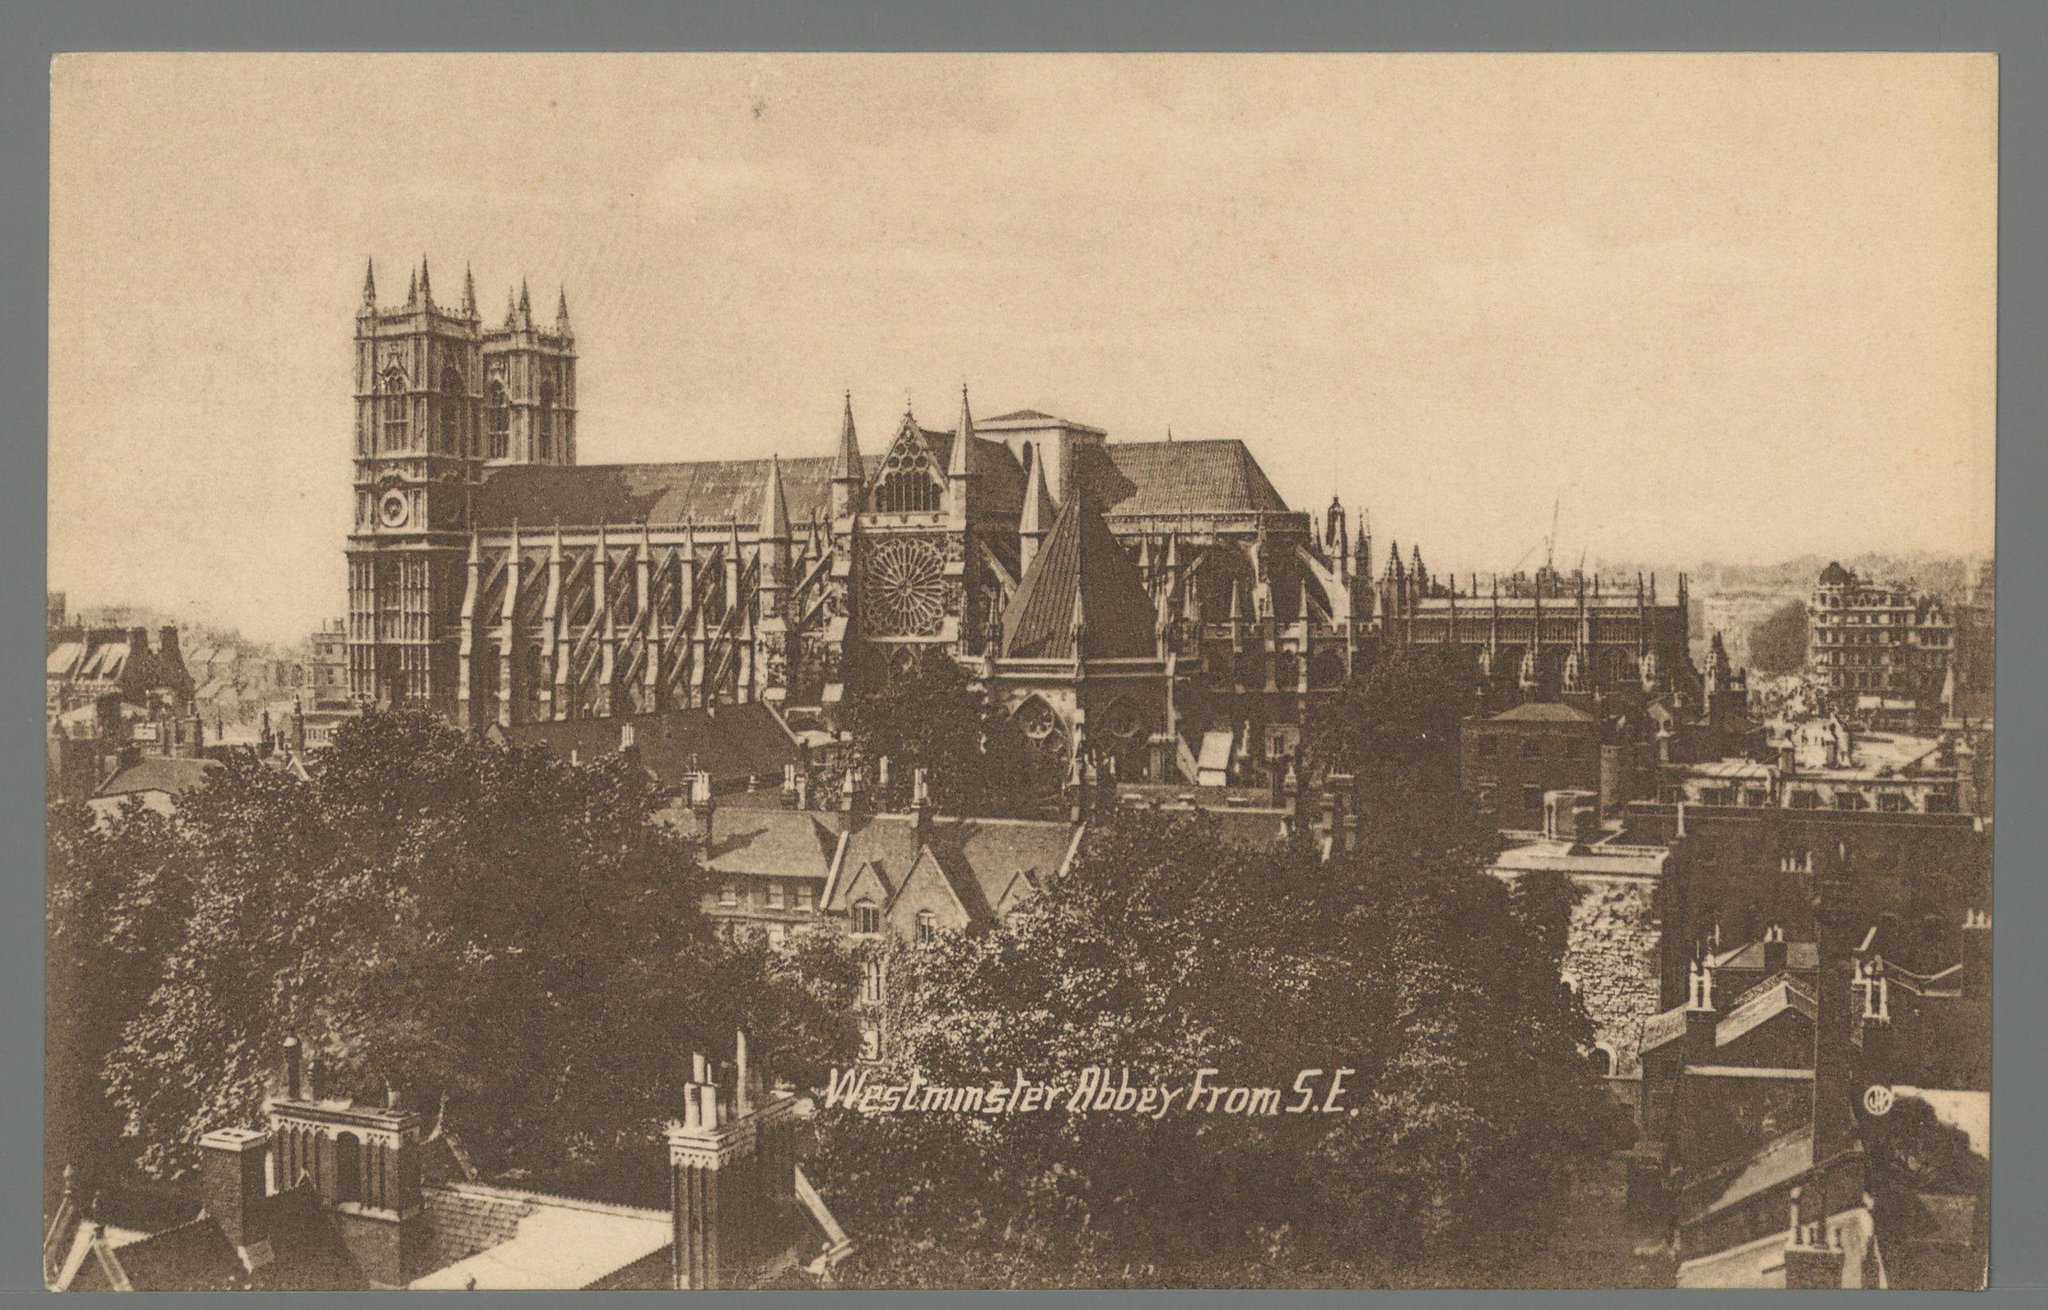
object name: photomechanical print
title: Valentine's Series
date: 1902-1930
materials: cardboard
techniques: photograph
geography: london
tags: church (exterior), westminster abbey